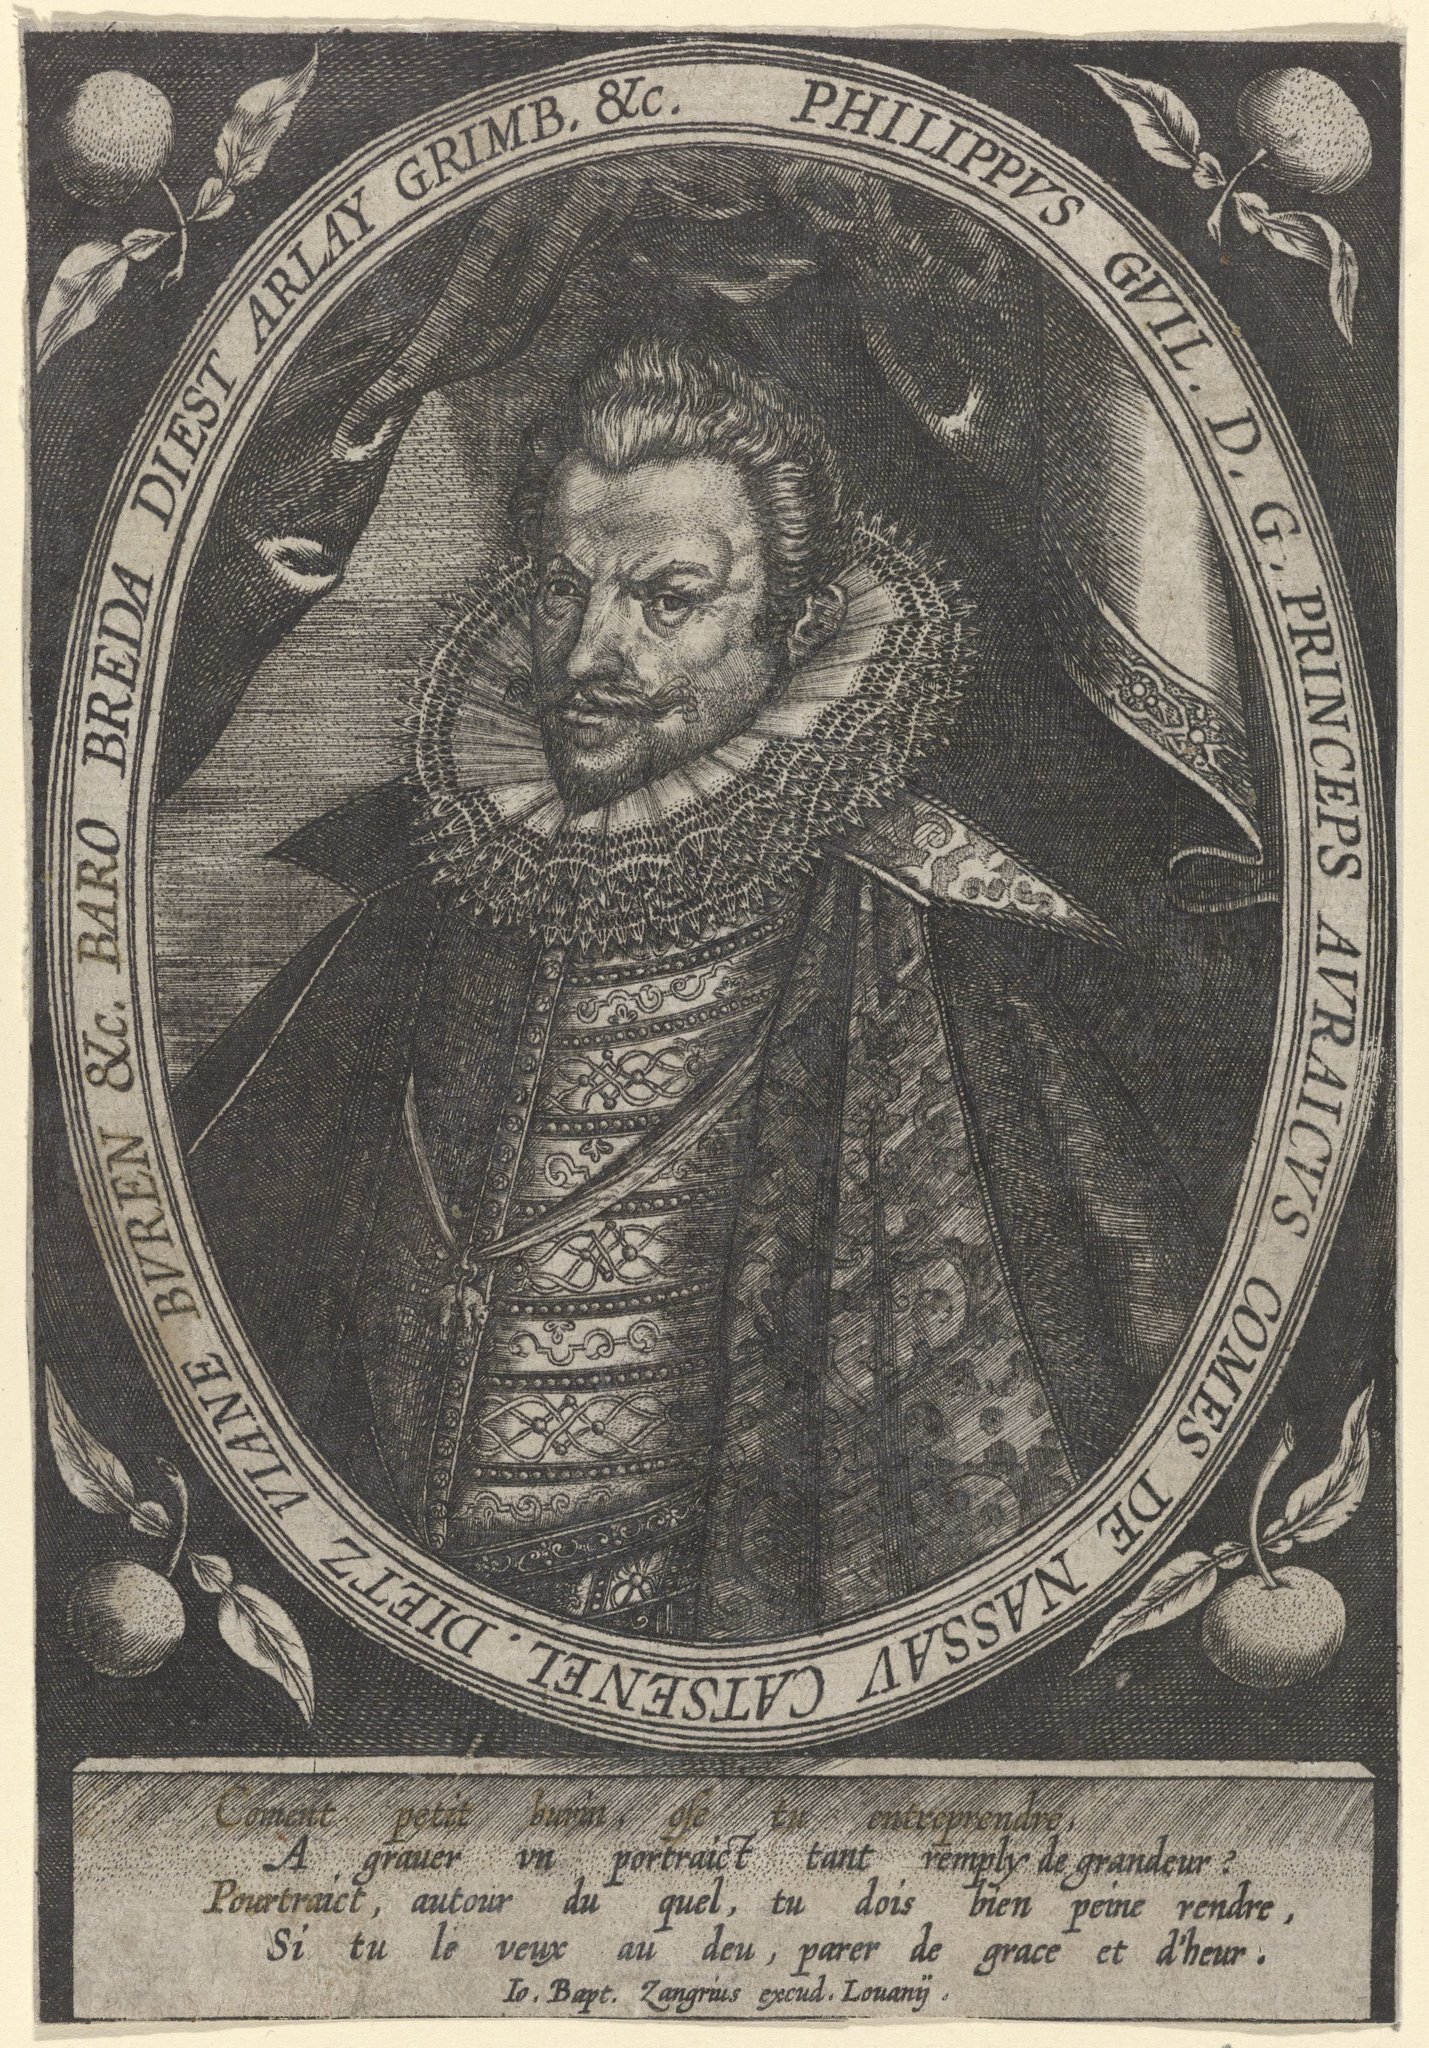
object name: print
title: Portret van Filips Willem, prins van Oranje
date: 1595-1606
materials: paper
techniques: engraving, etching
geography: low countries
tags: buren, bruges, filips willem (prins van oranje), knighthood order of the golden fleece - insignia of a knighthood order, e.g.: badge, chain (with name of order)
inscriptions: collector's mark: Lugt 963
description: De hier vermelde titel verwijst naar de hoogst verkregen titel van de geportretteerde, niet per se naar de titel die de geportretteerde op deze voorstelling draagt.